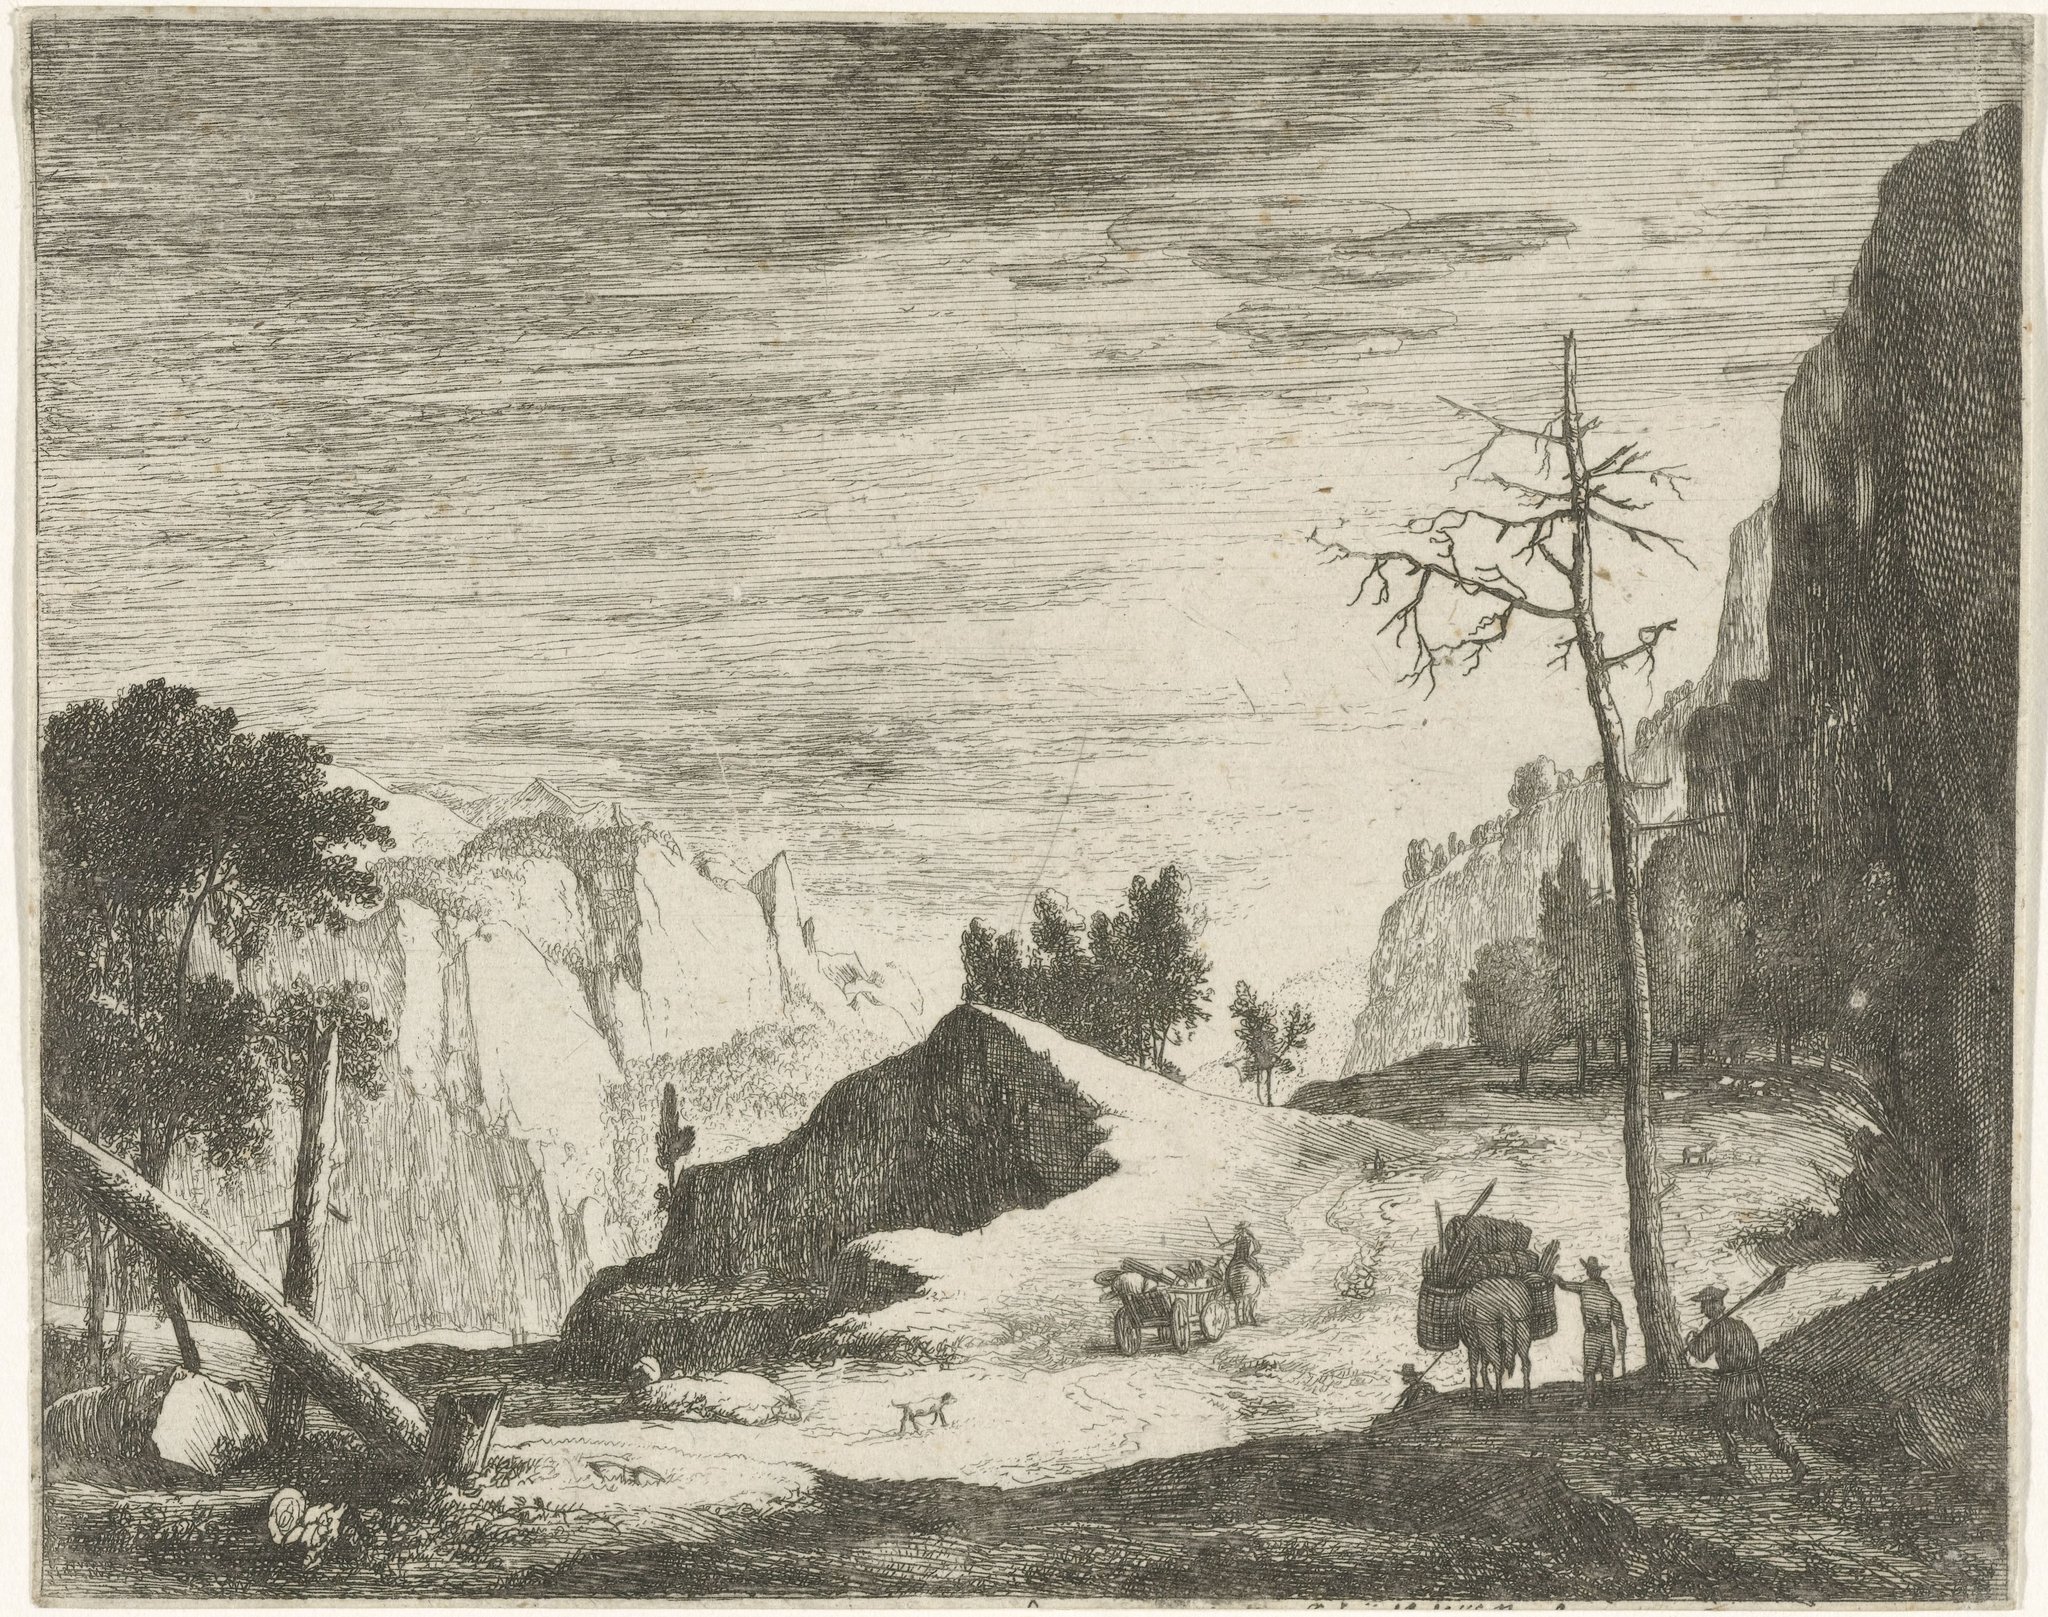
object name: print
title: Weg in een berglandschap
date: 1637-1683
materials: paper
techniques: etching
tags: animal traction, animal-drawn vehicle (carriage etc.), public road, dog, mountains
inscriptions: collector's mark: Lugt 2228a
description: Gezicht op een weg in een berglandschap. Over de weg vervoeren figuren goederen per ezel en per kar. Prent uit een serie van acht prenten met Tiroolse landschappen.